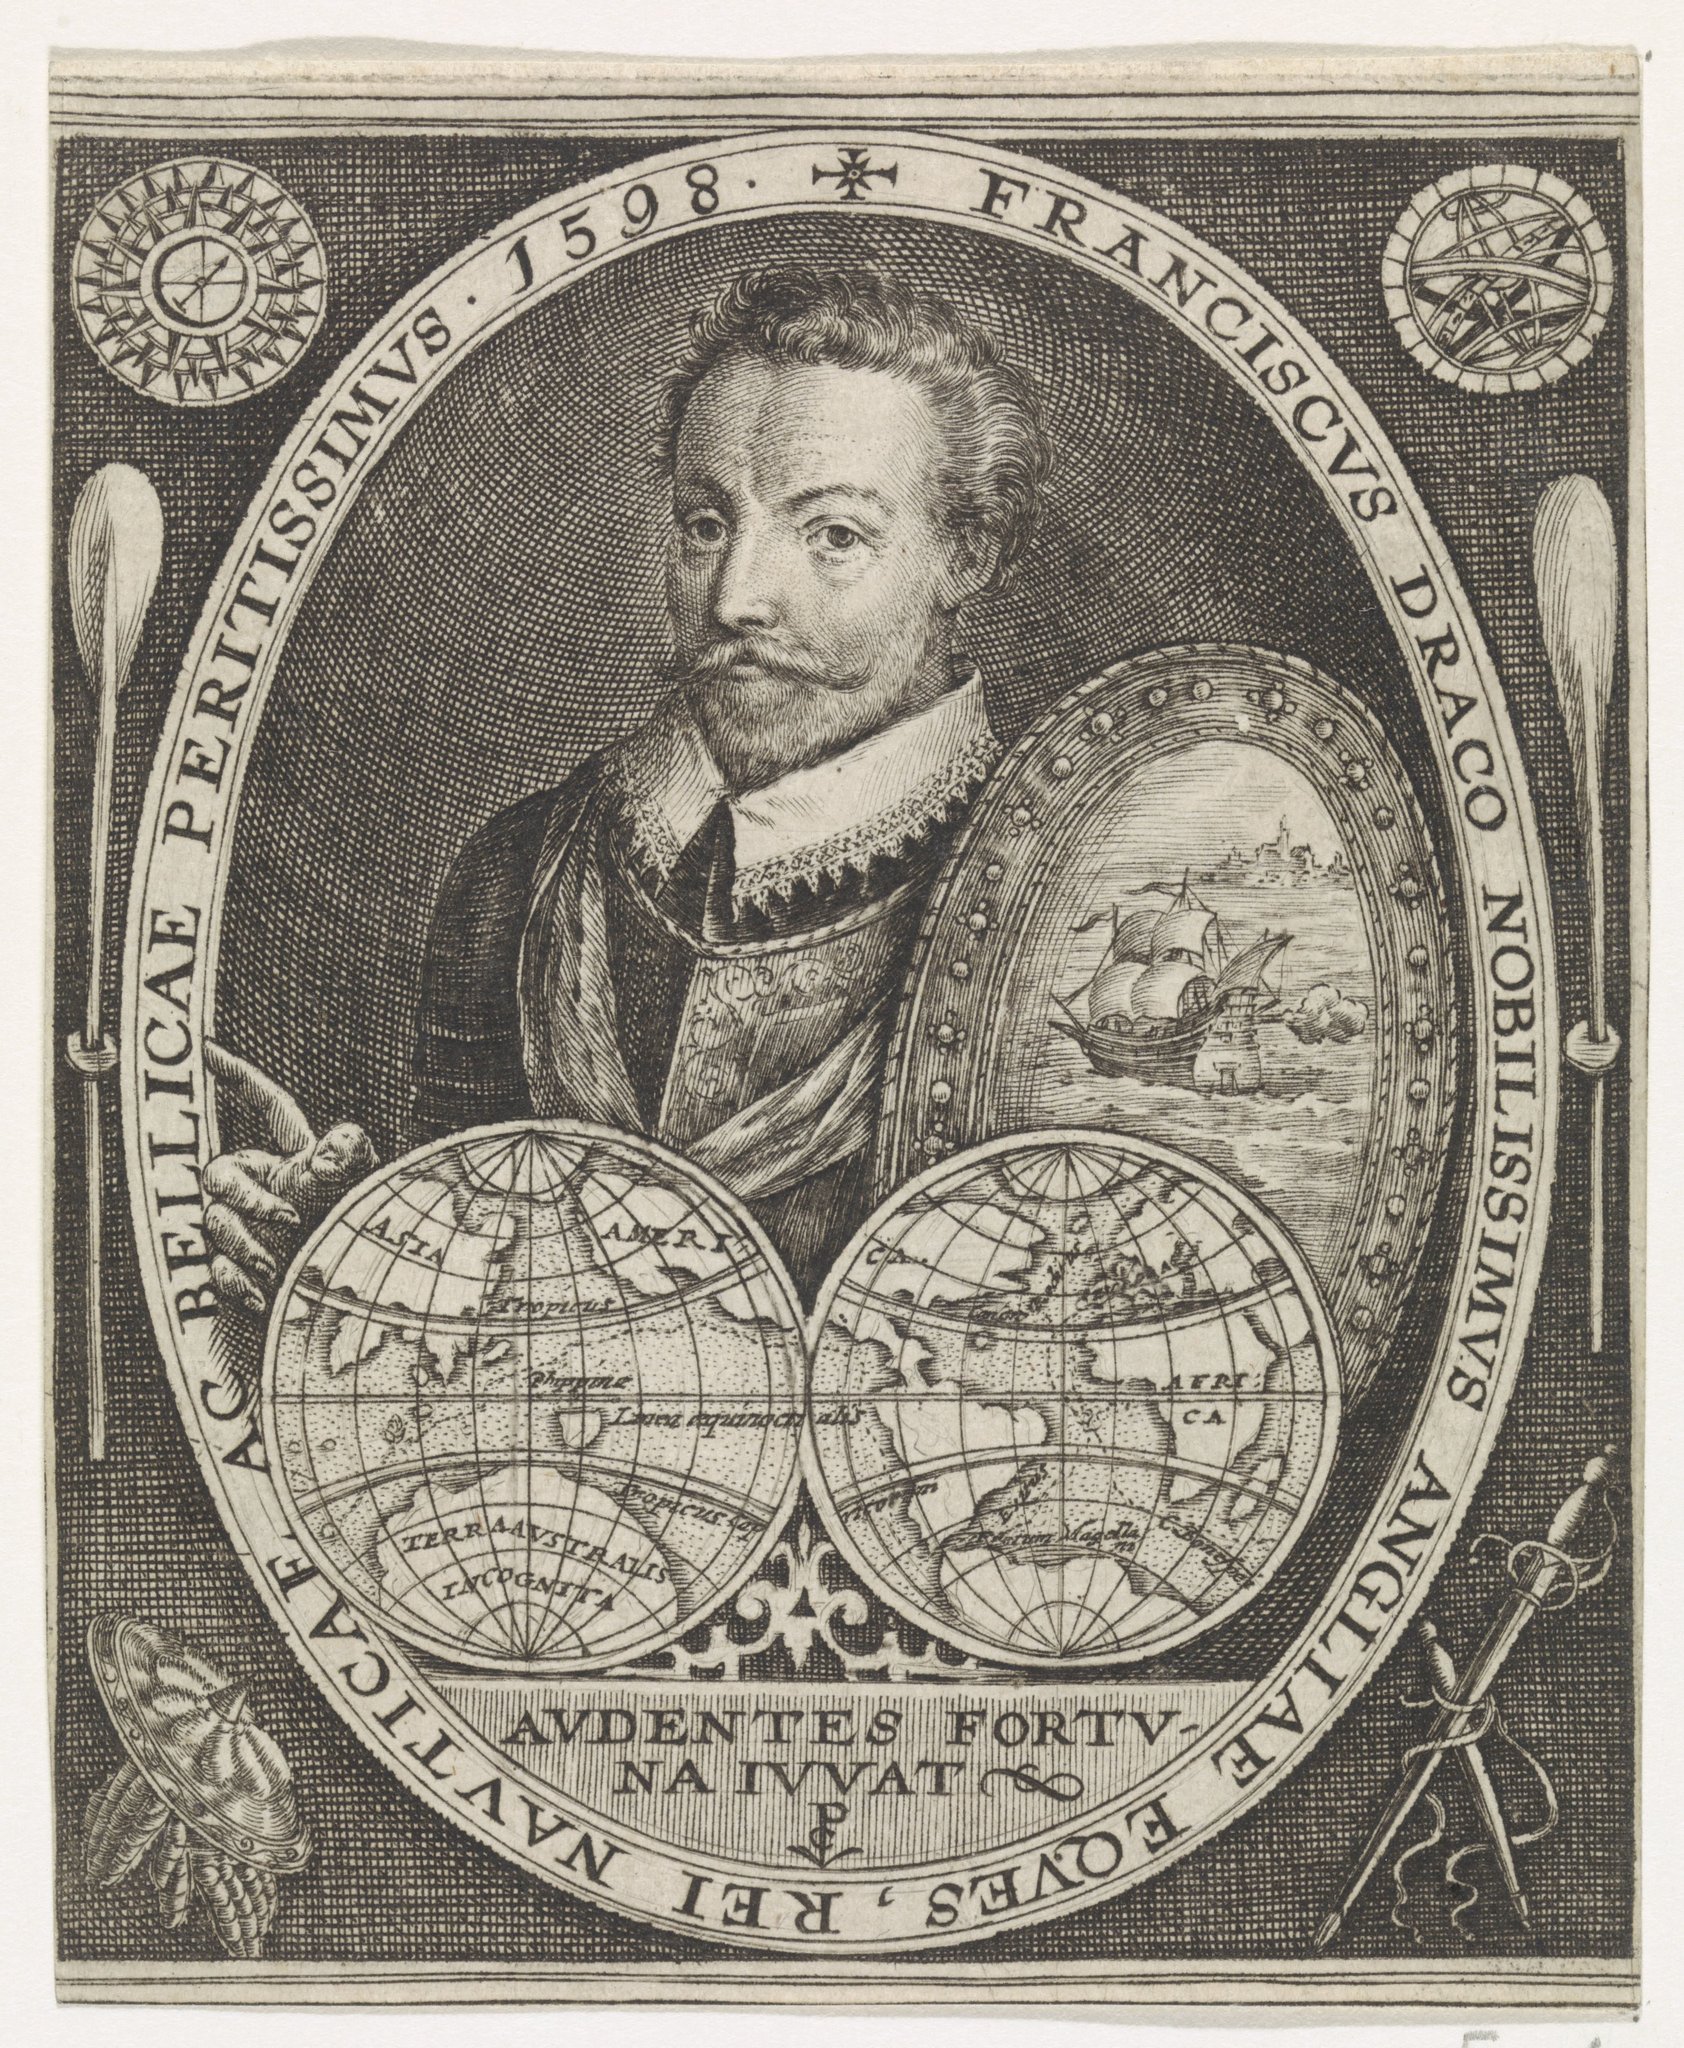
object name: print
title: Portret van Francis Drake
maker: crispijn van de passe (i)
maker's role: draughtsman, print maker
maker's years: 1564-1637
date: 1598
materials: paper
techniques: engraving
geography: cologne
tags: quadrant, sextant, octant (nautical instruments)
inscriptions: collector's mark: Lugt 2228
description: Portret van de ontdekkingsreiziger Sir Francis Drake, daaronder zijn devies in het Latijn. In het randschrift van de omlijsting de naam en functie van de geportretteerde in het Latijn. In de hoeken diverse navigatieinstrumenten.